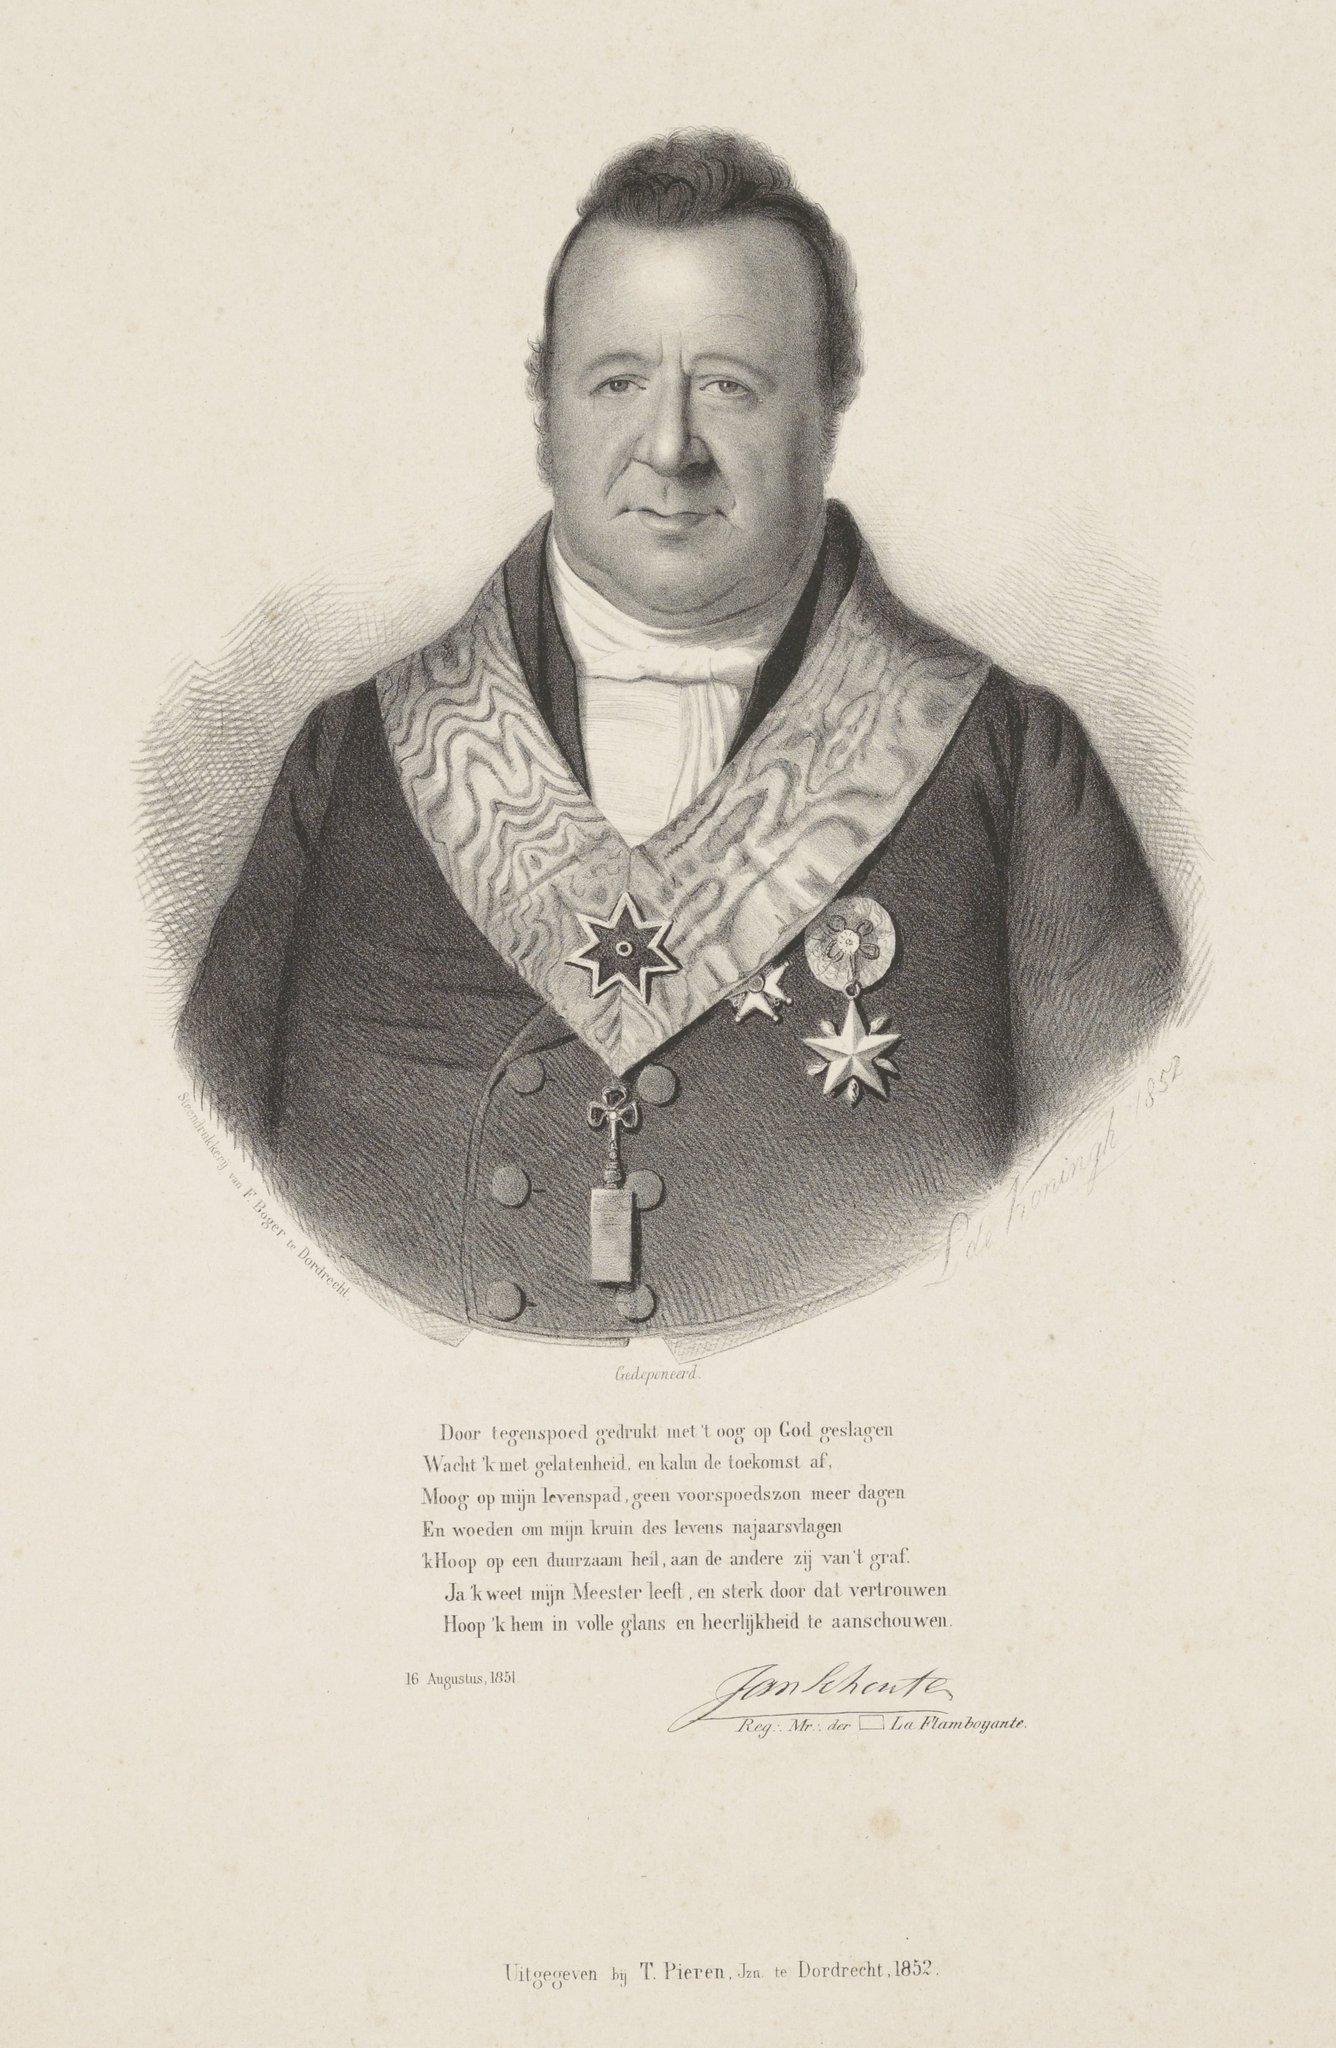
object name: print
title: Portret van Jan Schouten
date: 1852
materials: paper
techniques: lithograph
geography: dordrecht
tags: miscellaneous religions, cults and doctrines: freemasonry, historical persons (+ (full) bust portrait)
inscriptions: collector's mark: Lugt 2228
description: De geportretteerde draagt insignes van de vrijmetselarij. Onder het portret een zevenregelig gedicht door hemzelf.